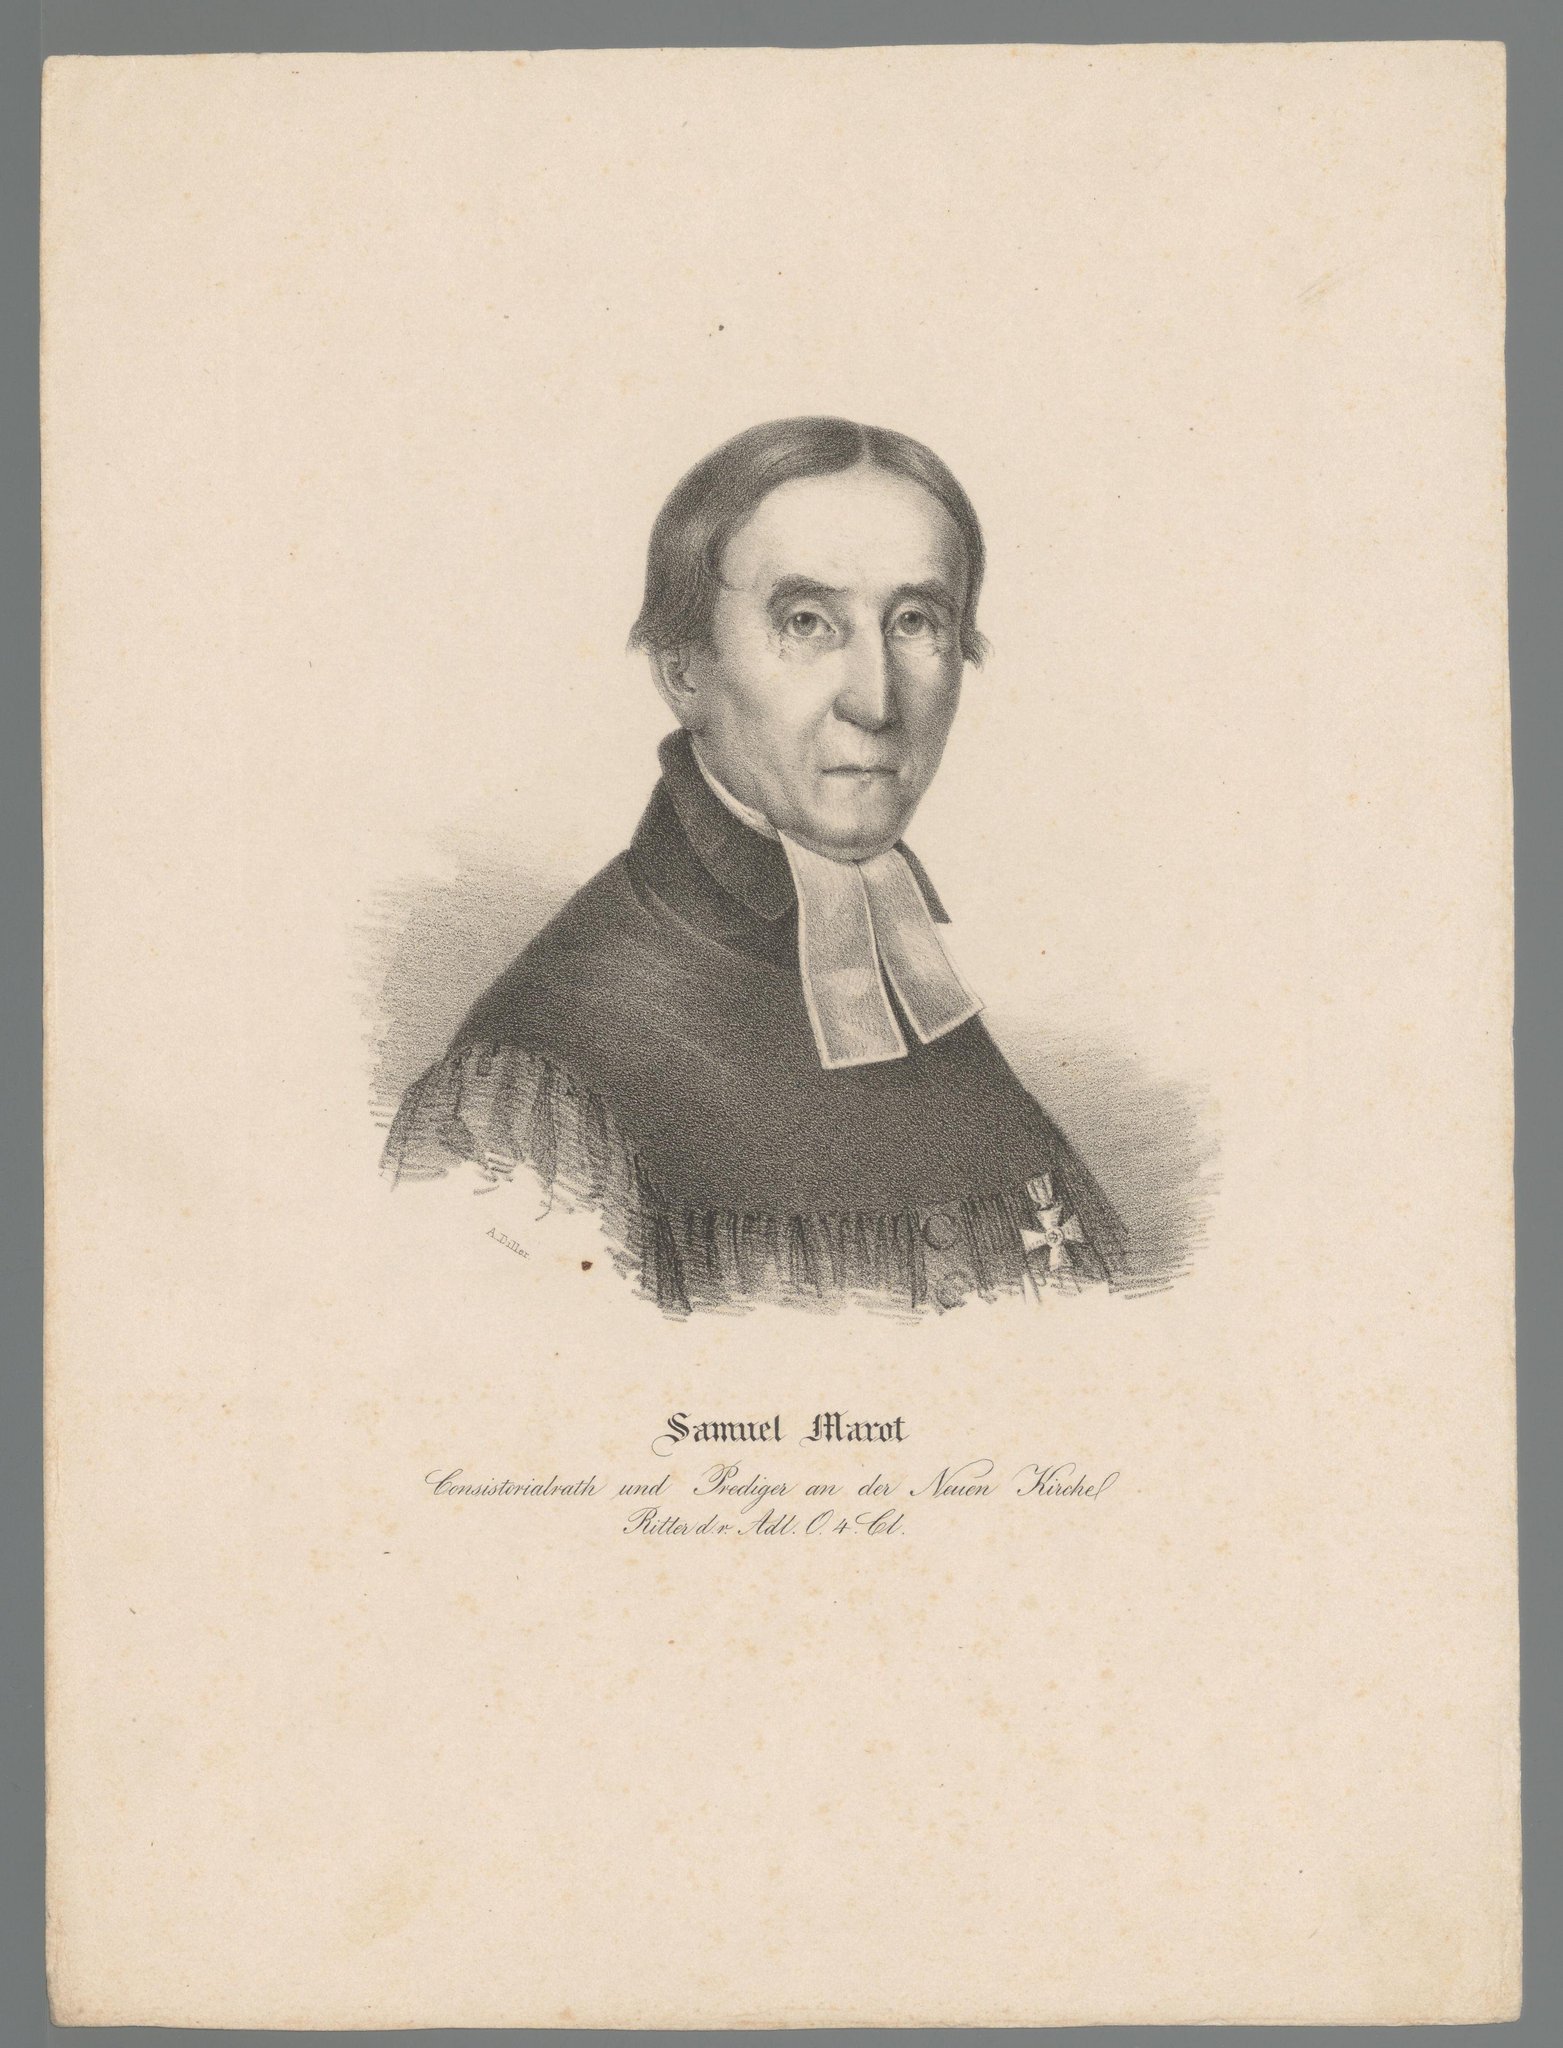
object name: print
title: Samuel Marot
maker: a. diller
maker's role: print maker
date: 1820-1850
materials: paper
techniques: lithograph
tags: adult man, historical persons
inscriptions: collector's mark: Lugt 2228